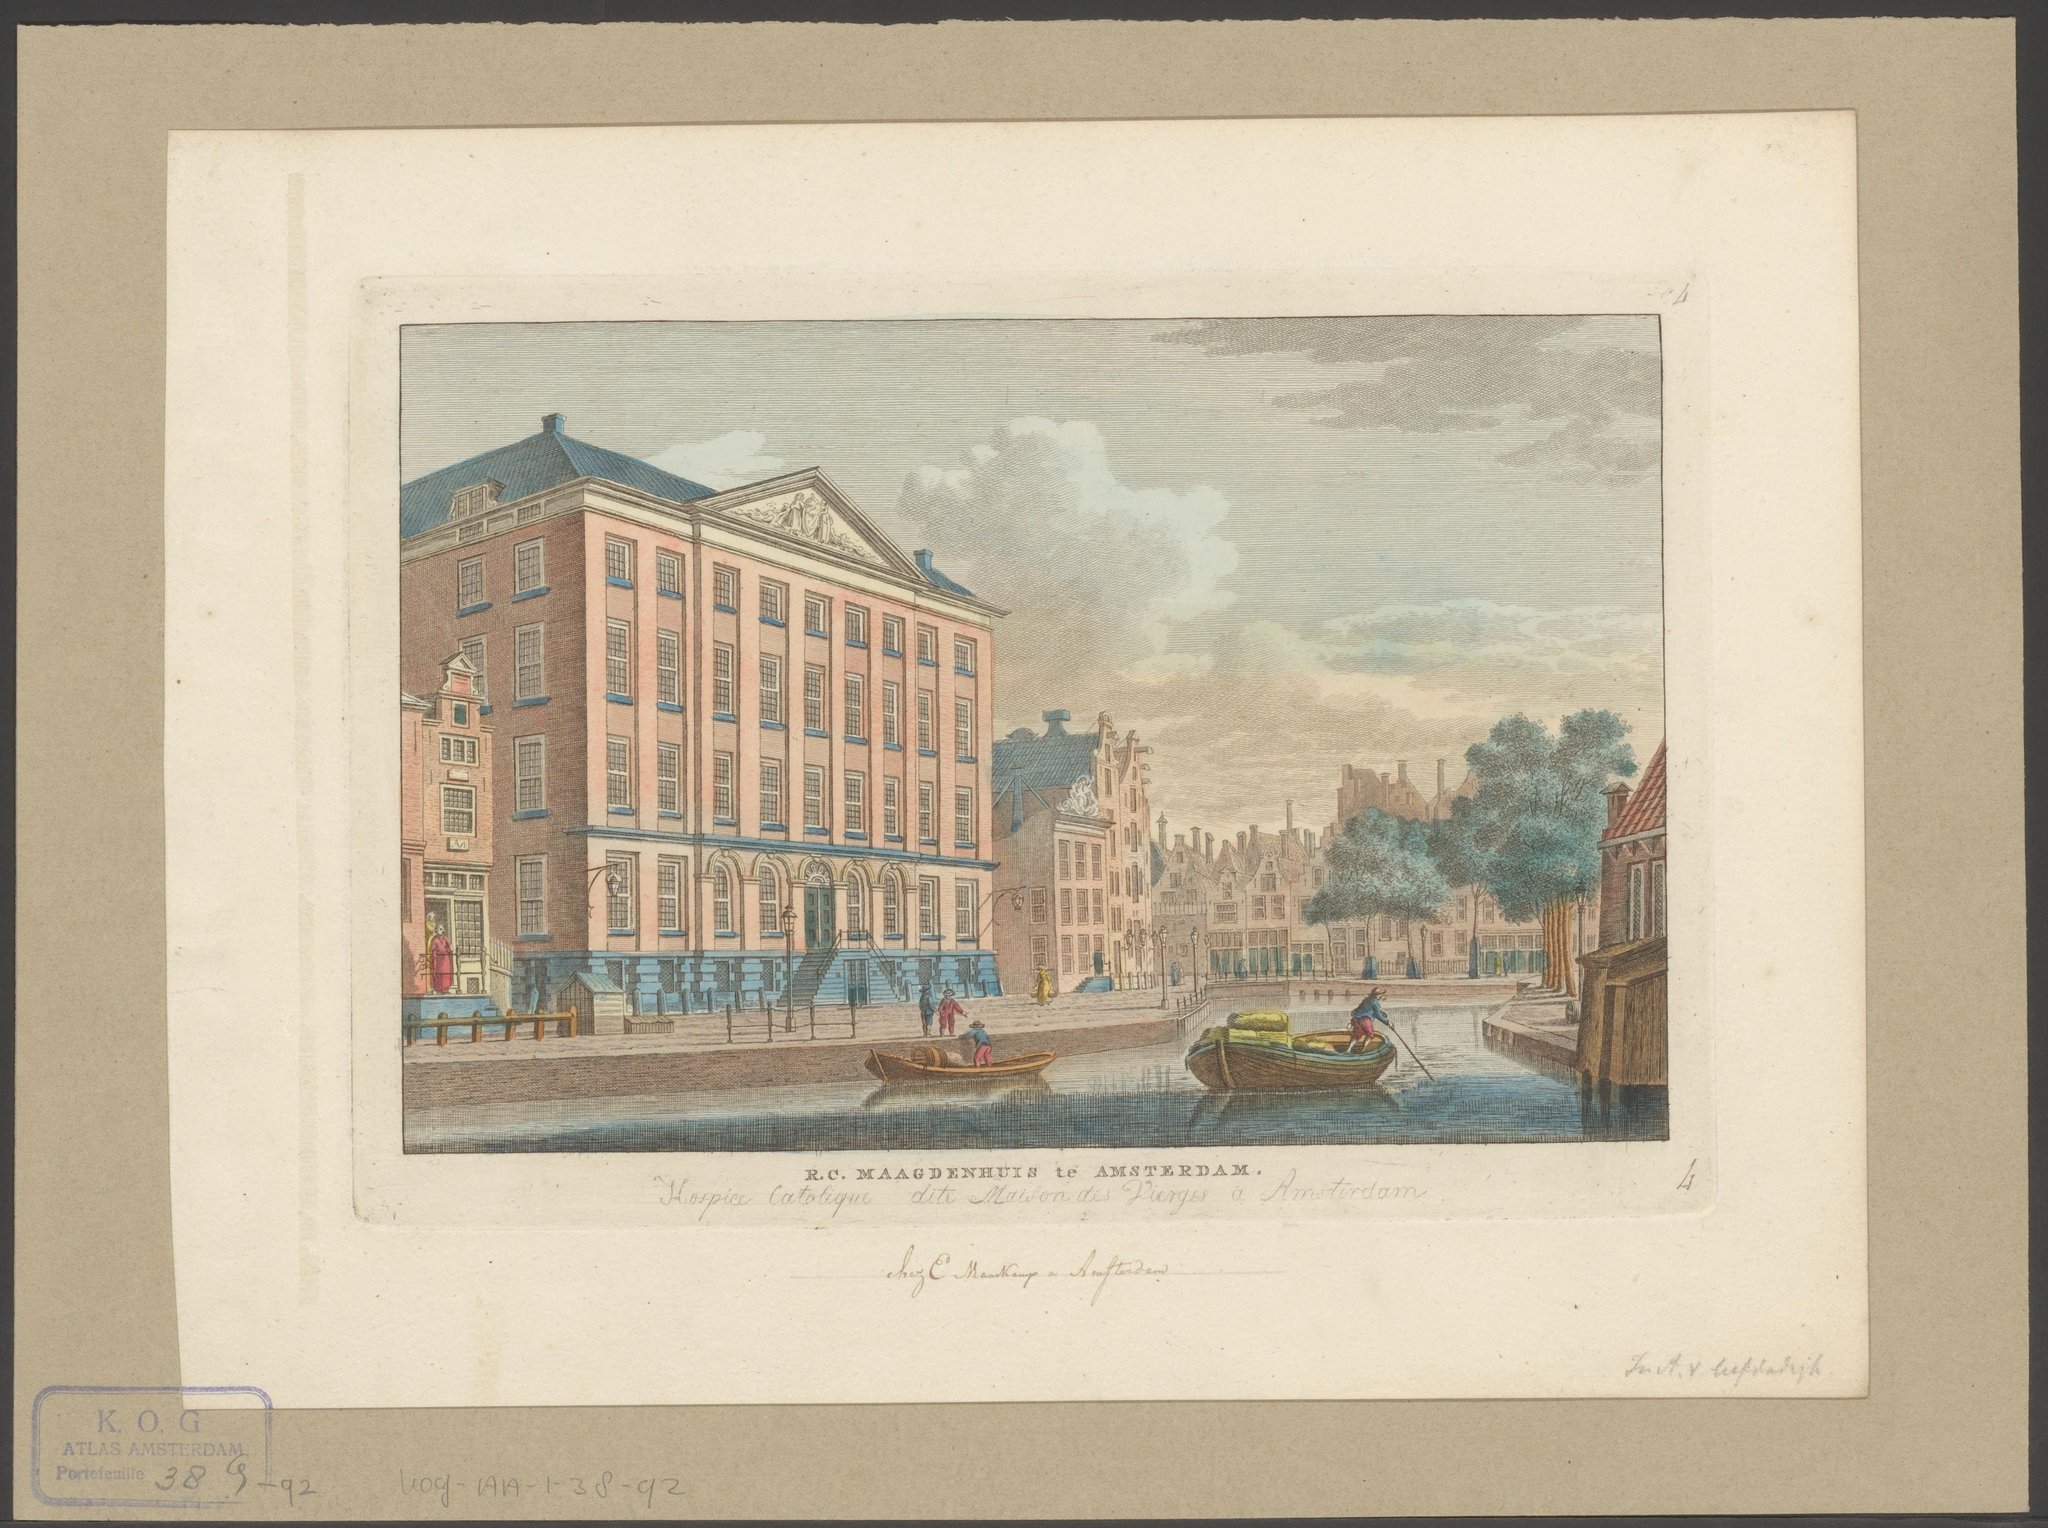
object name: print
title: Gezicht op het Maagdenhuis te Amsterdam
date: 1824-1825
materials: paper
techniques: engraving, etching, hand coloring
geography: amsterdam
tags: orphanage, canals, waters (in city) (+ city(-scape) with figures, staffage)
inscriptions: collector's mark: Lugt 1641b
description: Prent mogelijk uit: Tableau des Principales Vues des Palais et Édifices (...). Amsterdam: Evert Maaskamp, [1824-1825]. Eerdere staat van deze prent (zonder Franse titel) ook gebruikt in: Vaderlandsche gezichten, of afbeeldingen van den tegenwoordigen staat der Vereenigde Nederlanden (…). Amsterdam: Hendrik Gartman, Willem Vermandel en Jan Willem Smit, [1786-1792]. Alle prenten uit deze publicatie zijn gegraveerd door Carel Frederik Bendorp (I) en, in de meeste gevallen, gebaseerd op tekeningen van Jan Bulthuis.